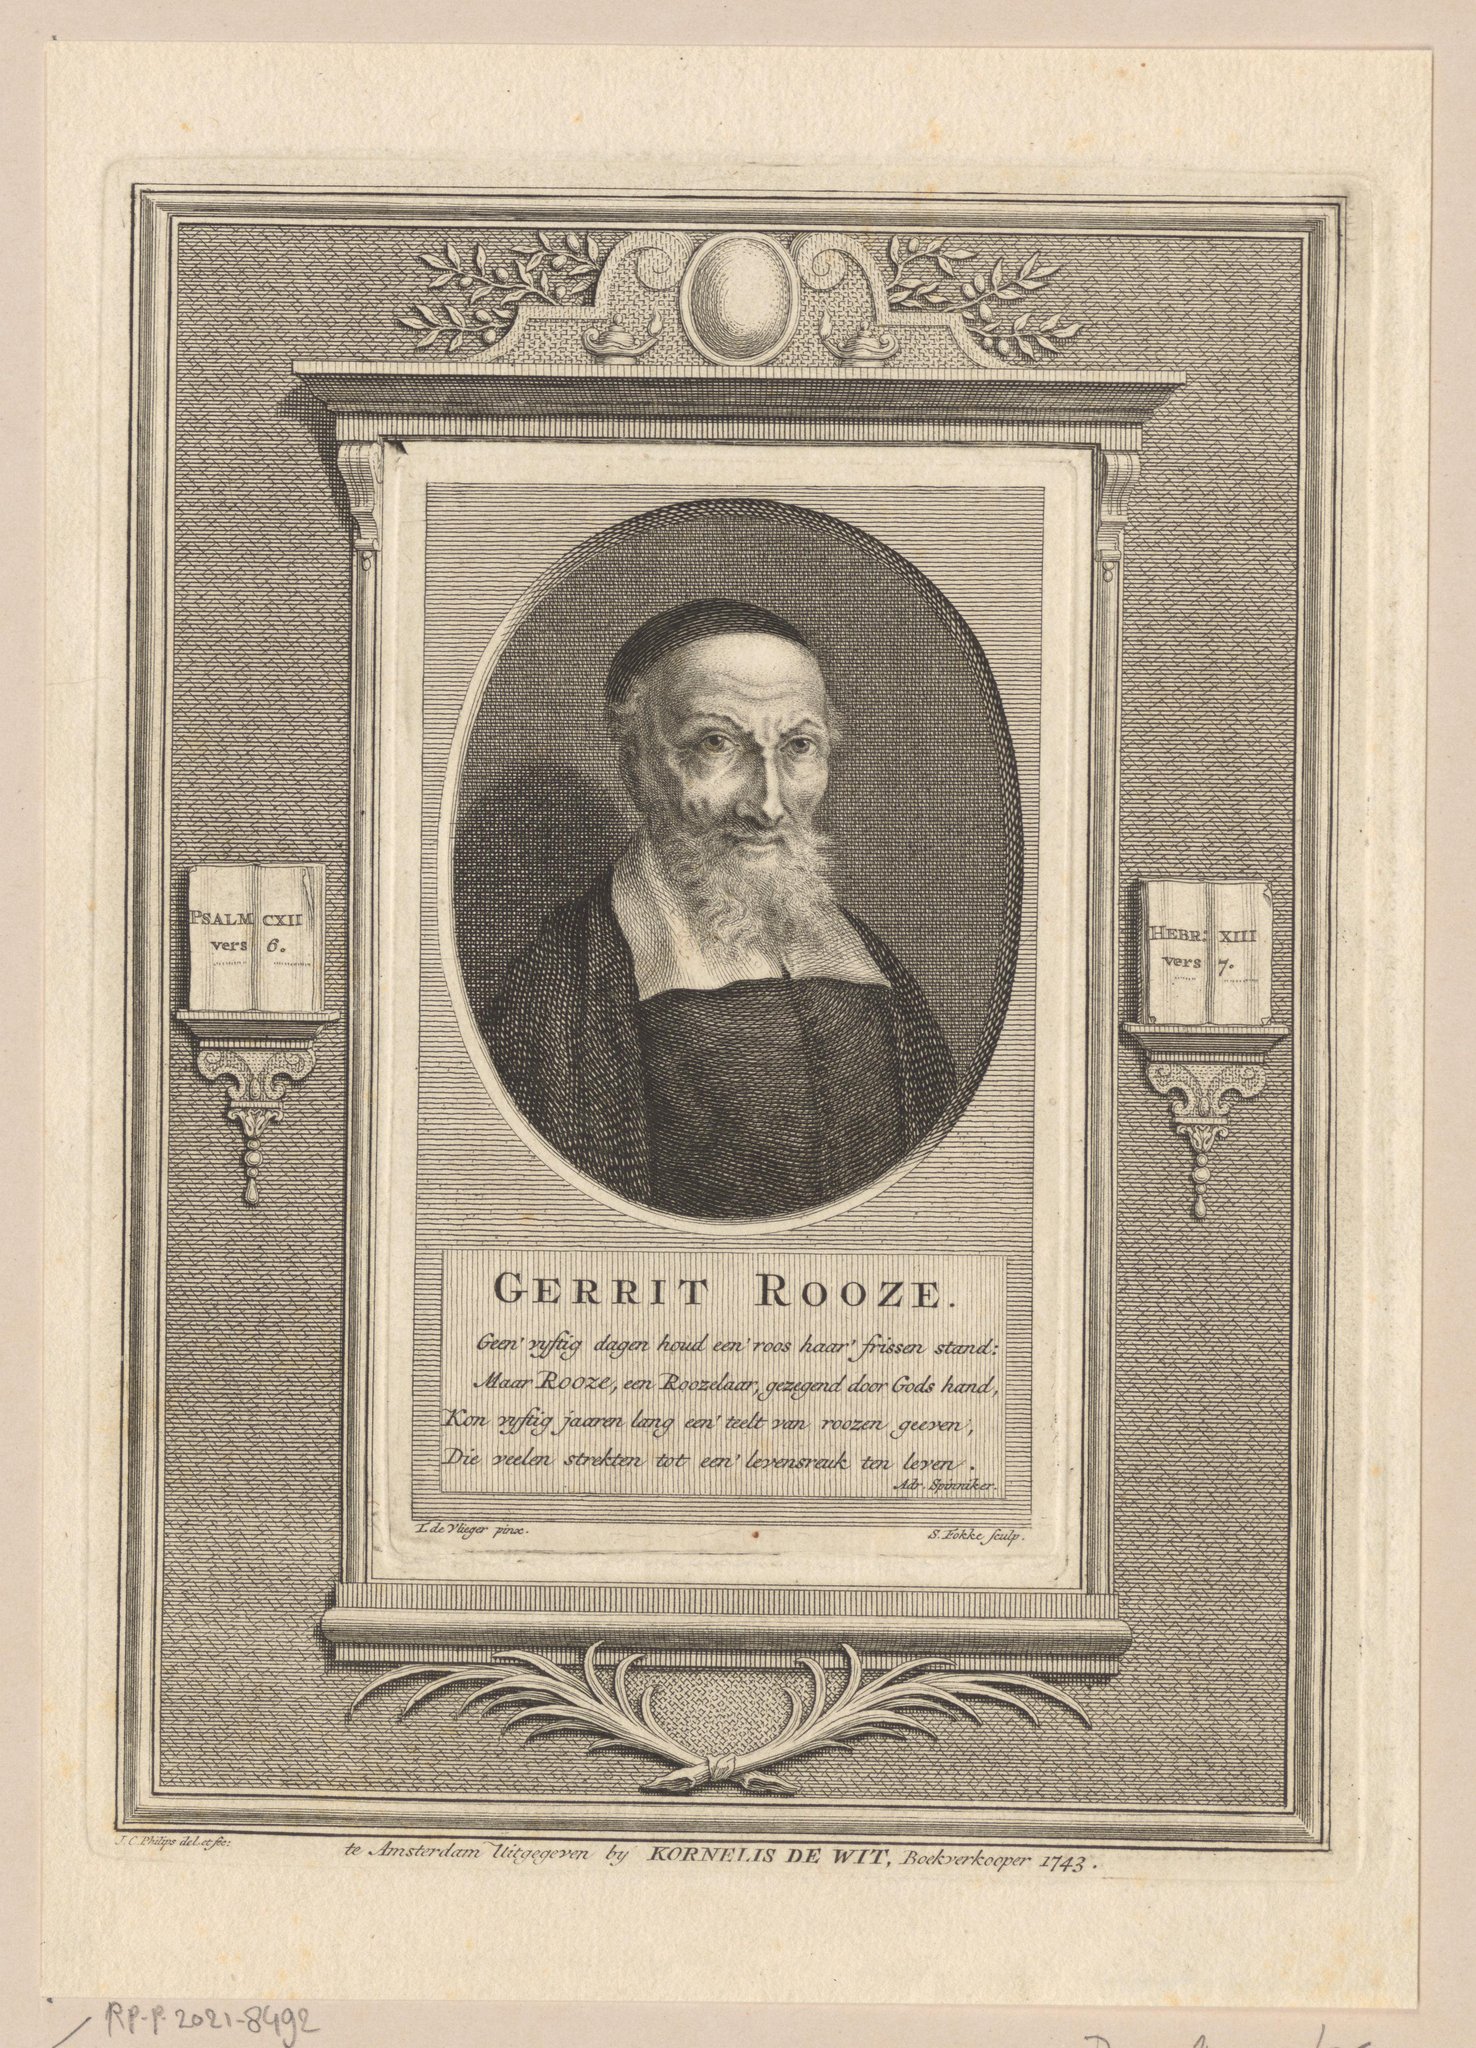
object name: print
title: Portret van Gerrit Rooze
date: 1743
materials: paper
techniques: engraving, etching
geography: amsterdam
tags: historical persons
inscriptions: date